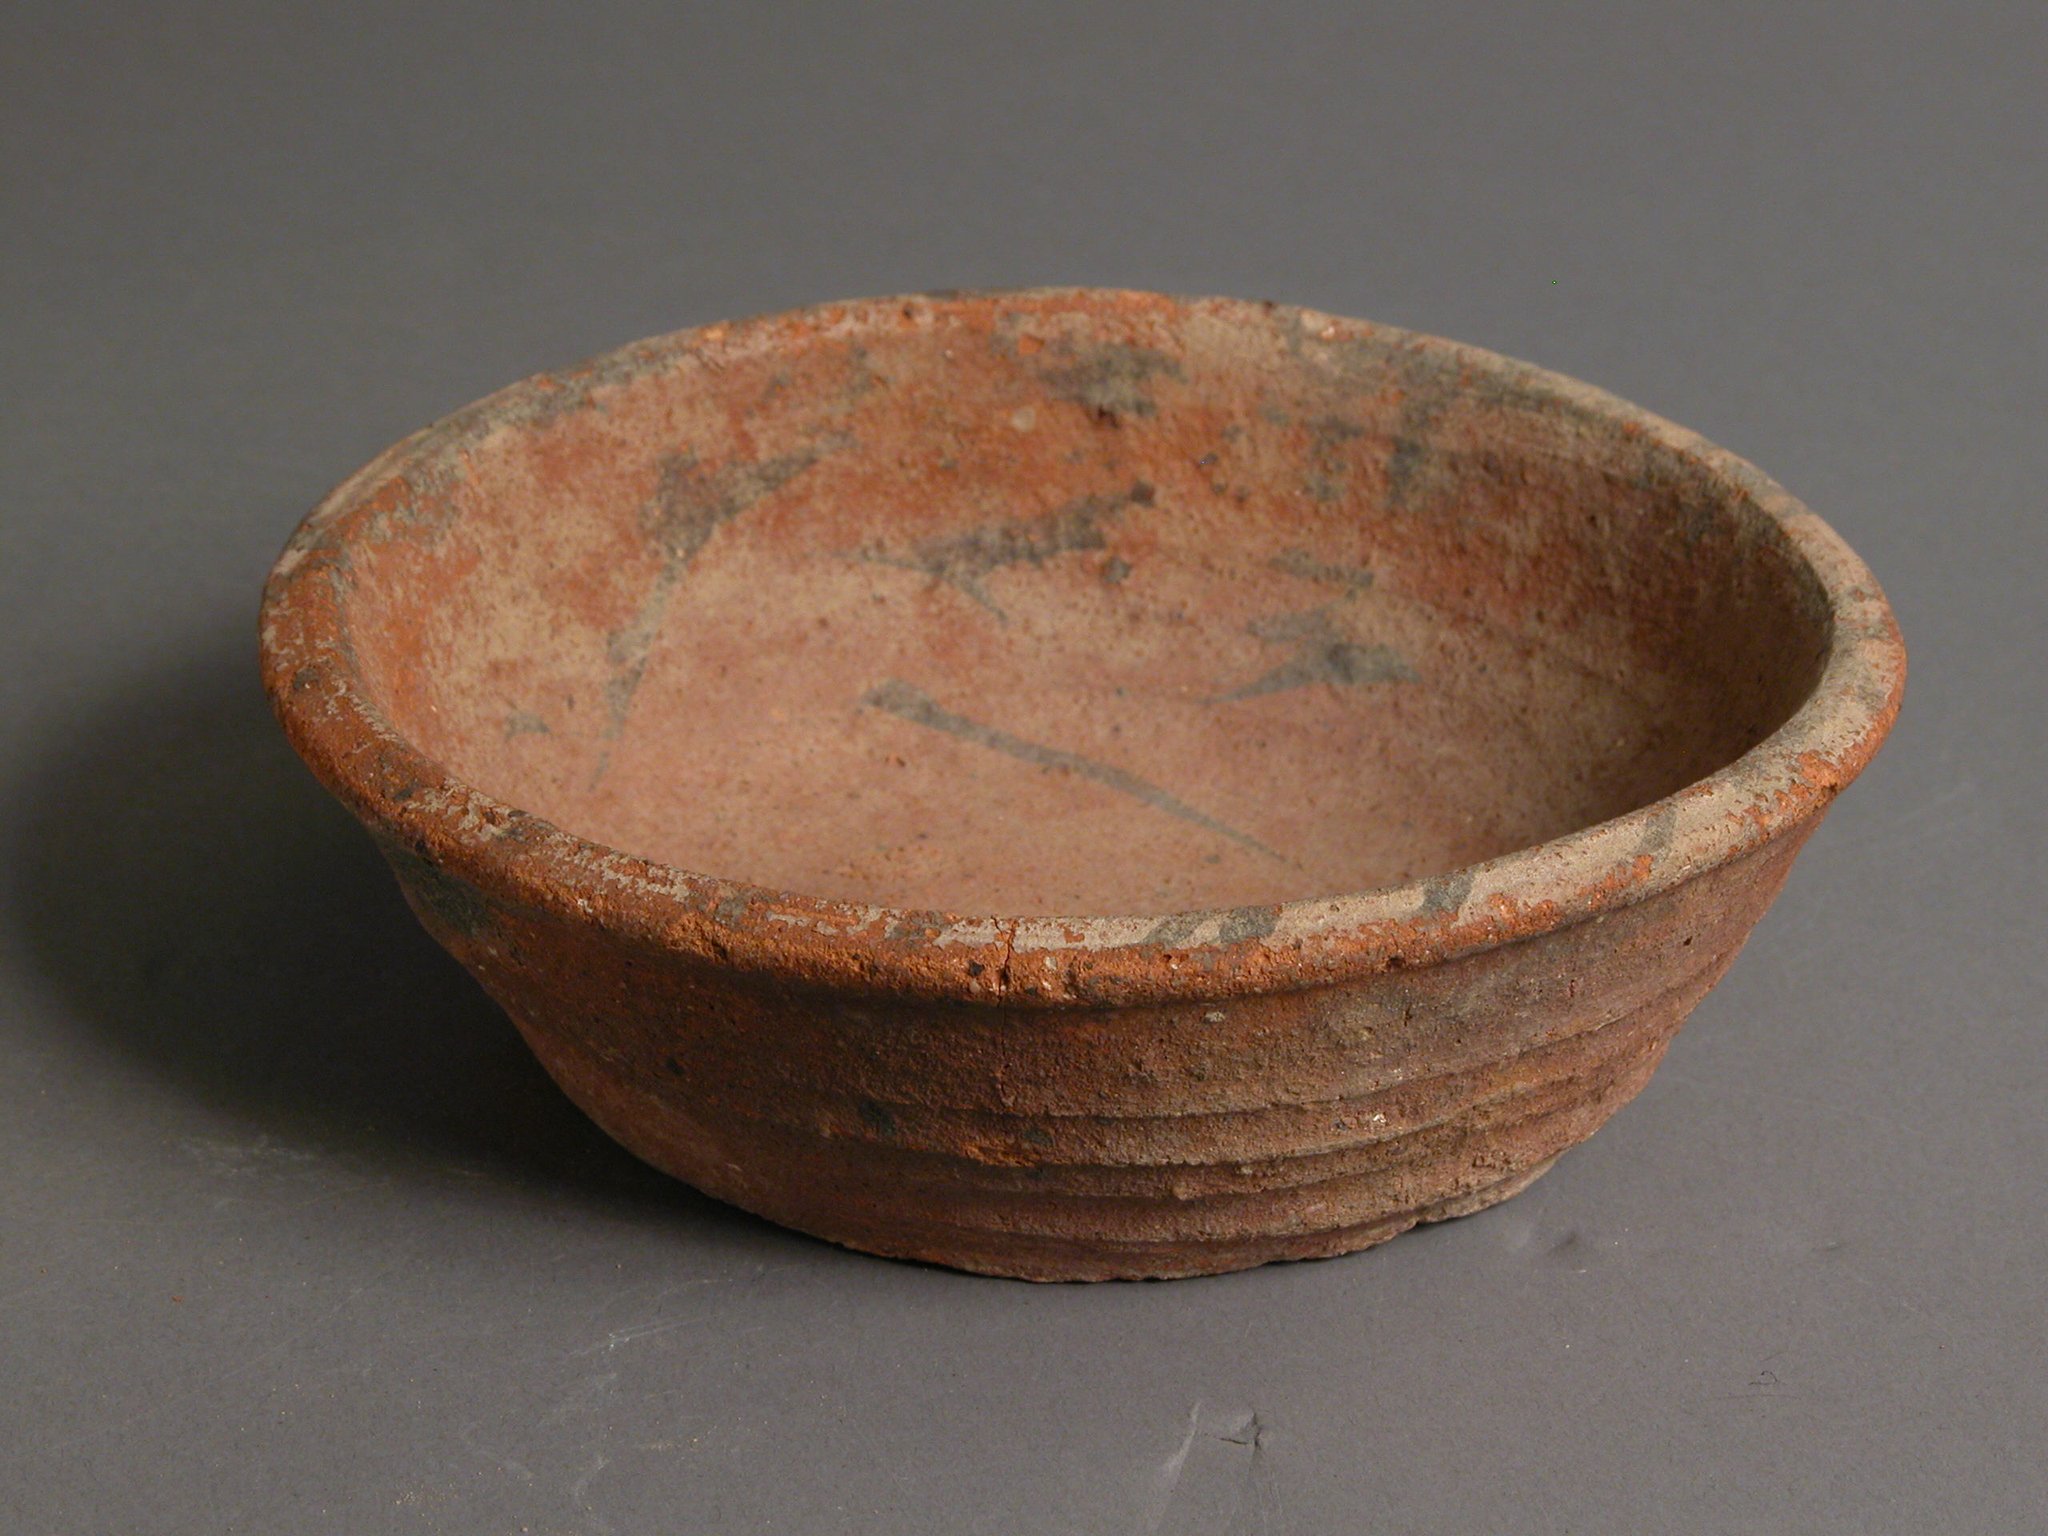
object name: bowl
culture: coptic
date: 301-700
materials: earthenware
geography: egypt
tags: bowls